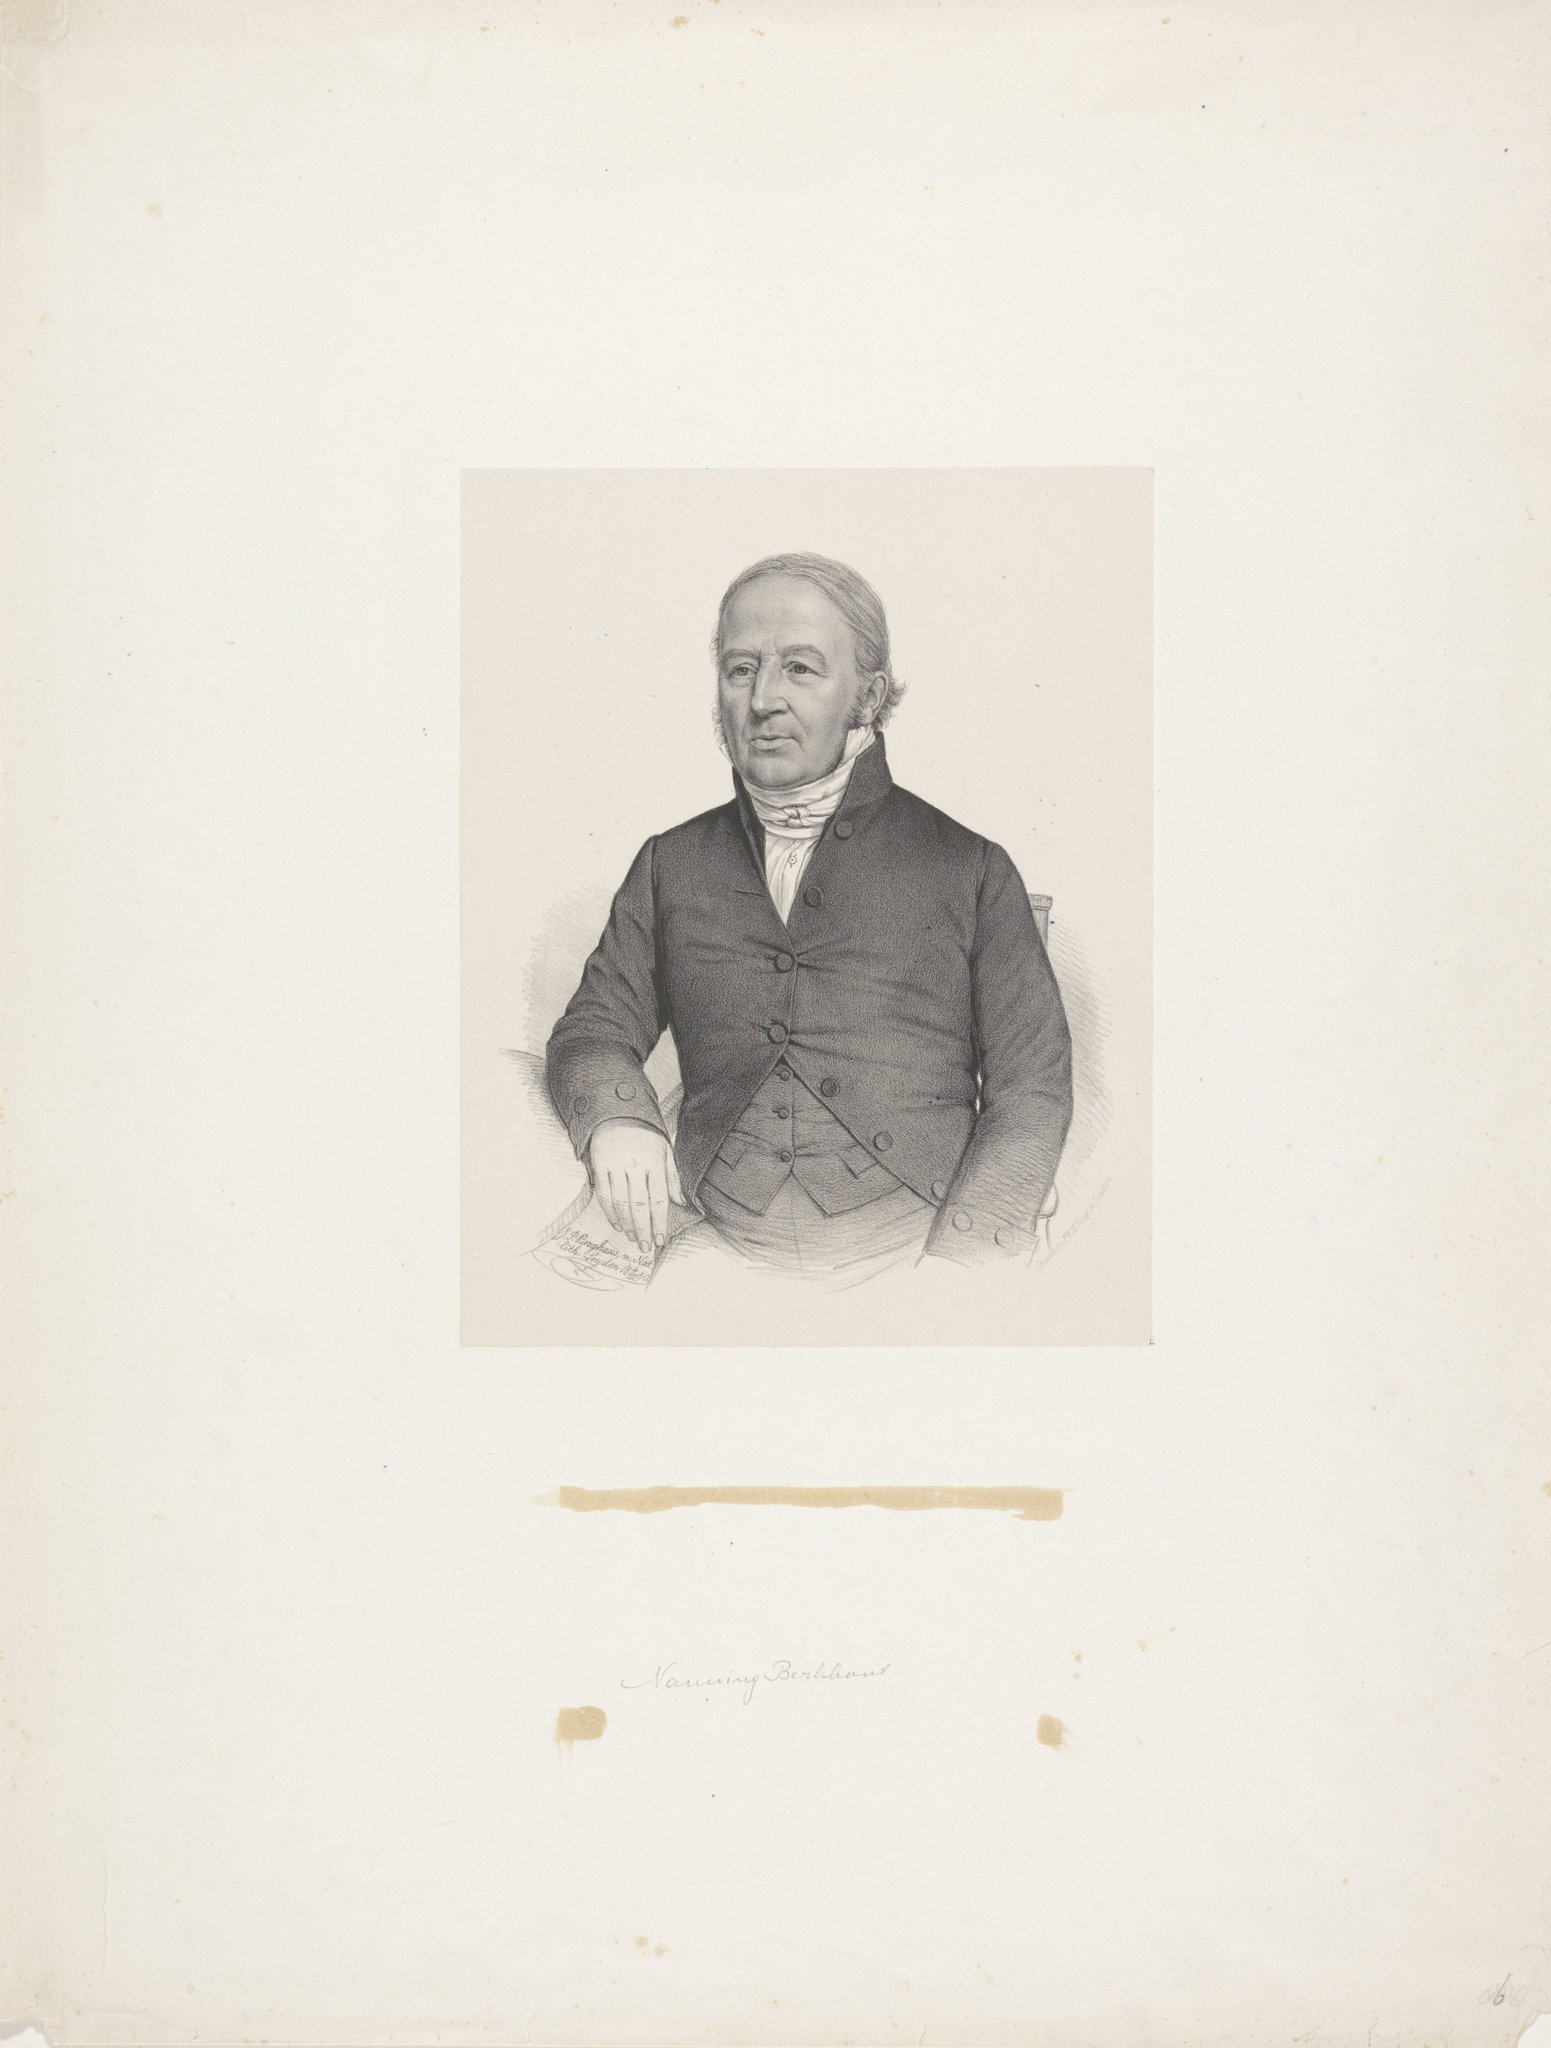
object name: print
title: Portret van Nanning Berkhout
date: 1850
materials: paper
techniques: lithograph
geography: leiden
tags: maarssen, leiden, historical persons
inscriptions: collector's mark: Lugt 2228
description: De geportretteerde leunt met zijn rechterarm op de tafel naast hem.